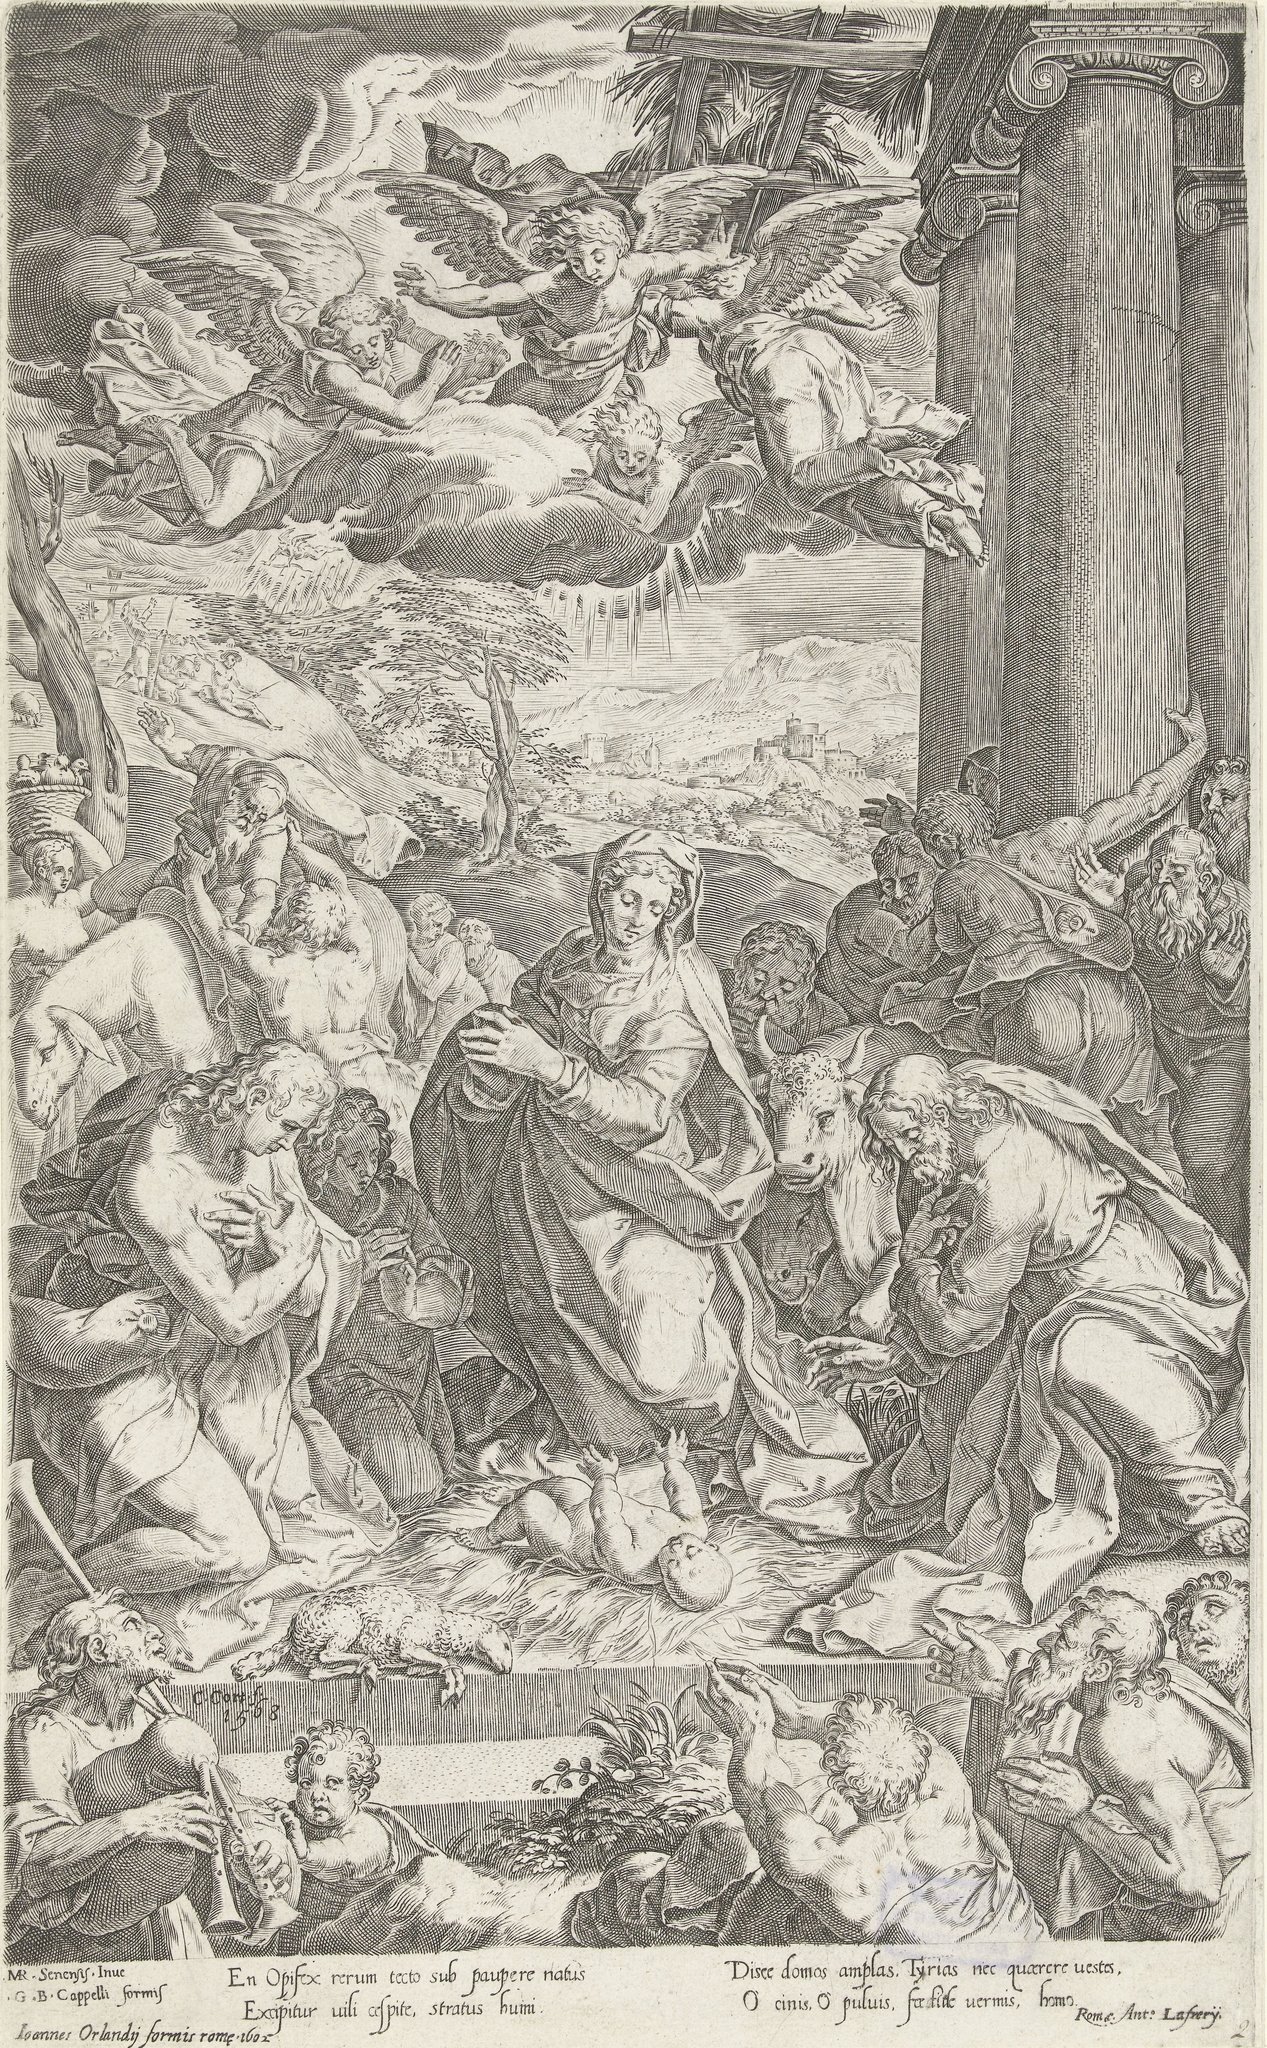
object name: print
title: Aanbidding door de herders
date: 1569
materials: paper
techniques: engraving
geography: rome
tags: adoration of the christ-child by the shepherds; mary and joseph present, annunciation of christ's birth to the shepherds (and/or shepherdesses) at night; a host of singing angels in the air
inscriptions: collector's mark: Lugt 11, date: ‘1568’, address: ‘Ioannes Orlandij formis romae’, caption: ‘En Opifex rerum tecto sub paupere natus / Excipitur vili cespite, stratus humi // Disce domos amplas. Tyrias nec qaerere vestes / O cinis, O pulvis, faectide vermis, homo.’, address: ‘G.B. Capelli formis’, date: ‘1602’, signature: ‘MAR Senensis Inve’, collector's mark: Lugt 10, signature: ‘C. Cort f.’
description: In het midden zitten Maria en Jozef geknield voor het Kind dat op een bundel stro op de grond ligt. Naast Christus ligt een lam. Een groep herders knielt in aanbidding eromheen. De herder linksvoor bespeelt een doedelzak. In de lucht engelen op een wolk. Rechtsachter de zuilen van een antiek gebouw. Linksachter, in een glooiend landschap, de verkondiging aan de herders.